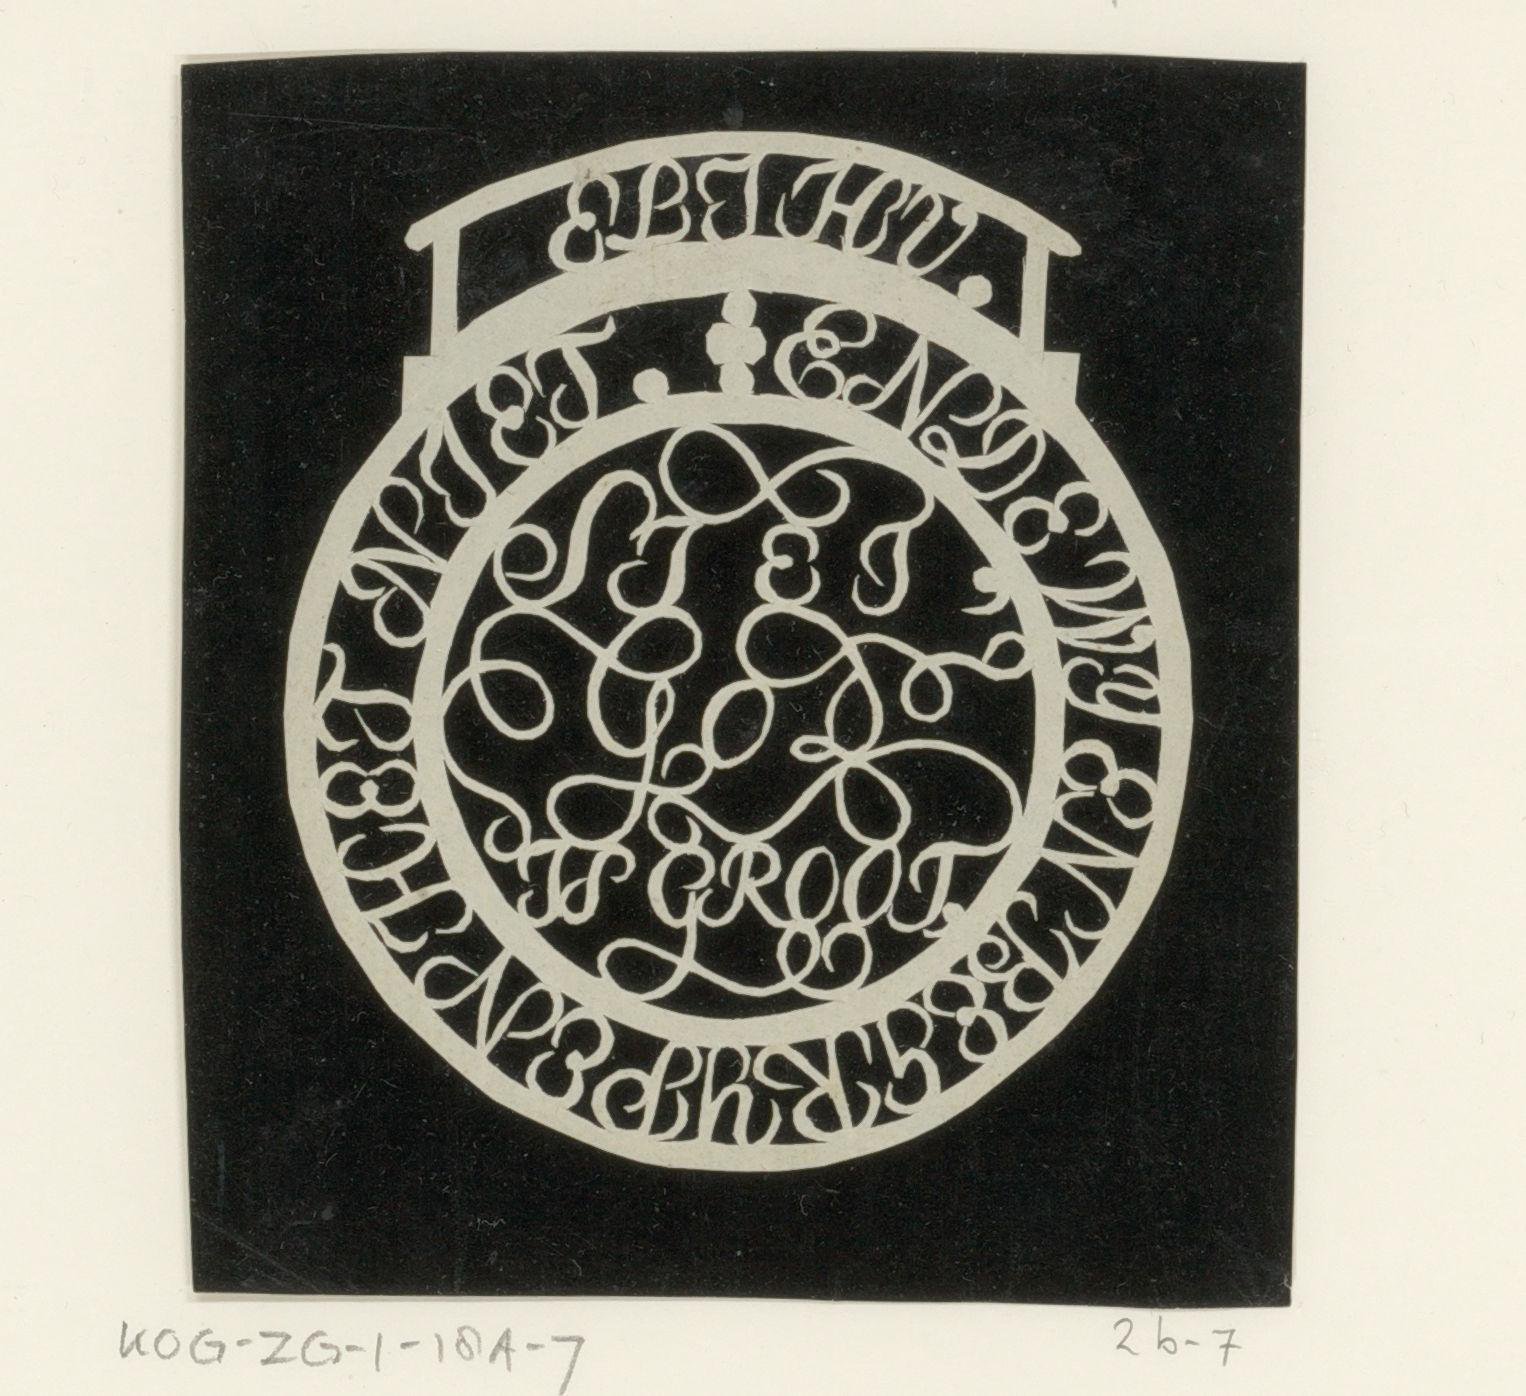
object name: cut paper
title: Spreuk: Siet God is groot, ende wij en begrijpen het niet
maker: Anonymous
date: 1750-1849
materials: paper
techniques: cutting, snipping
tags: word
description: Onderwerpsrubrieken binnen de Atlas Zeden en Gewoonten: Schoone kunsten, Knipkunst.